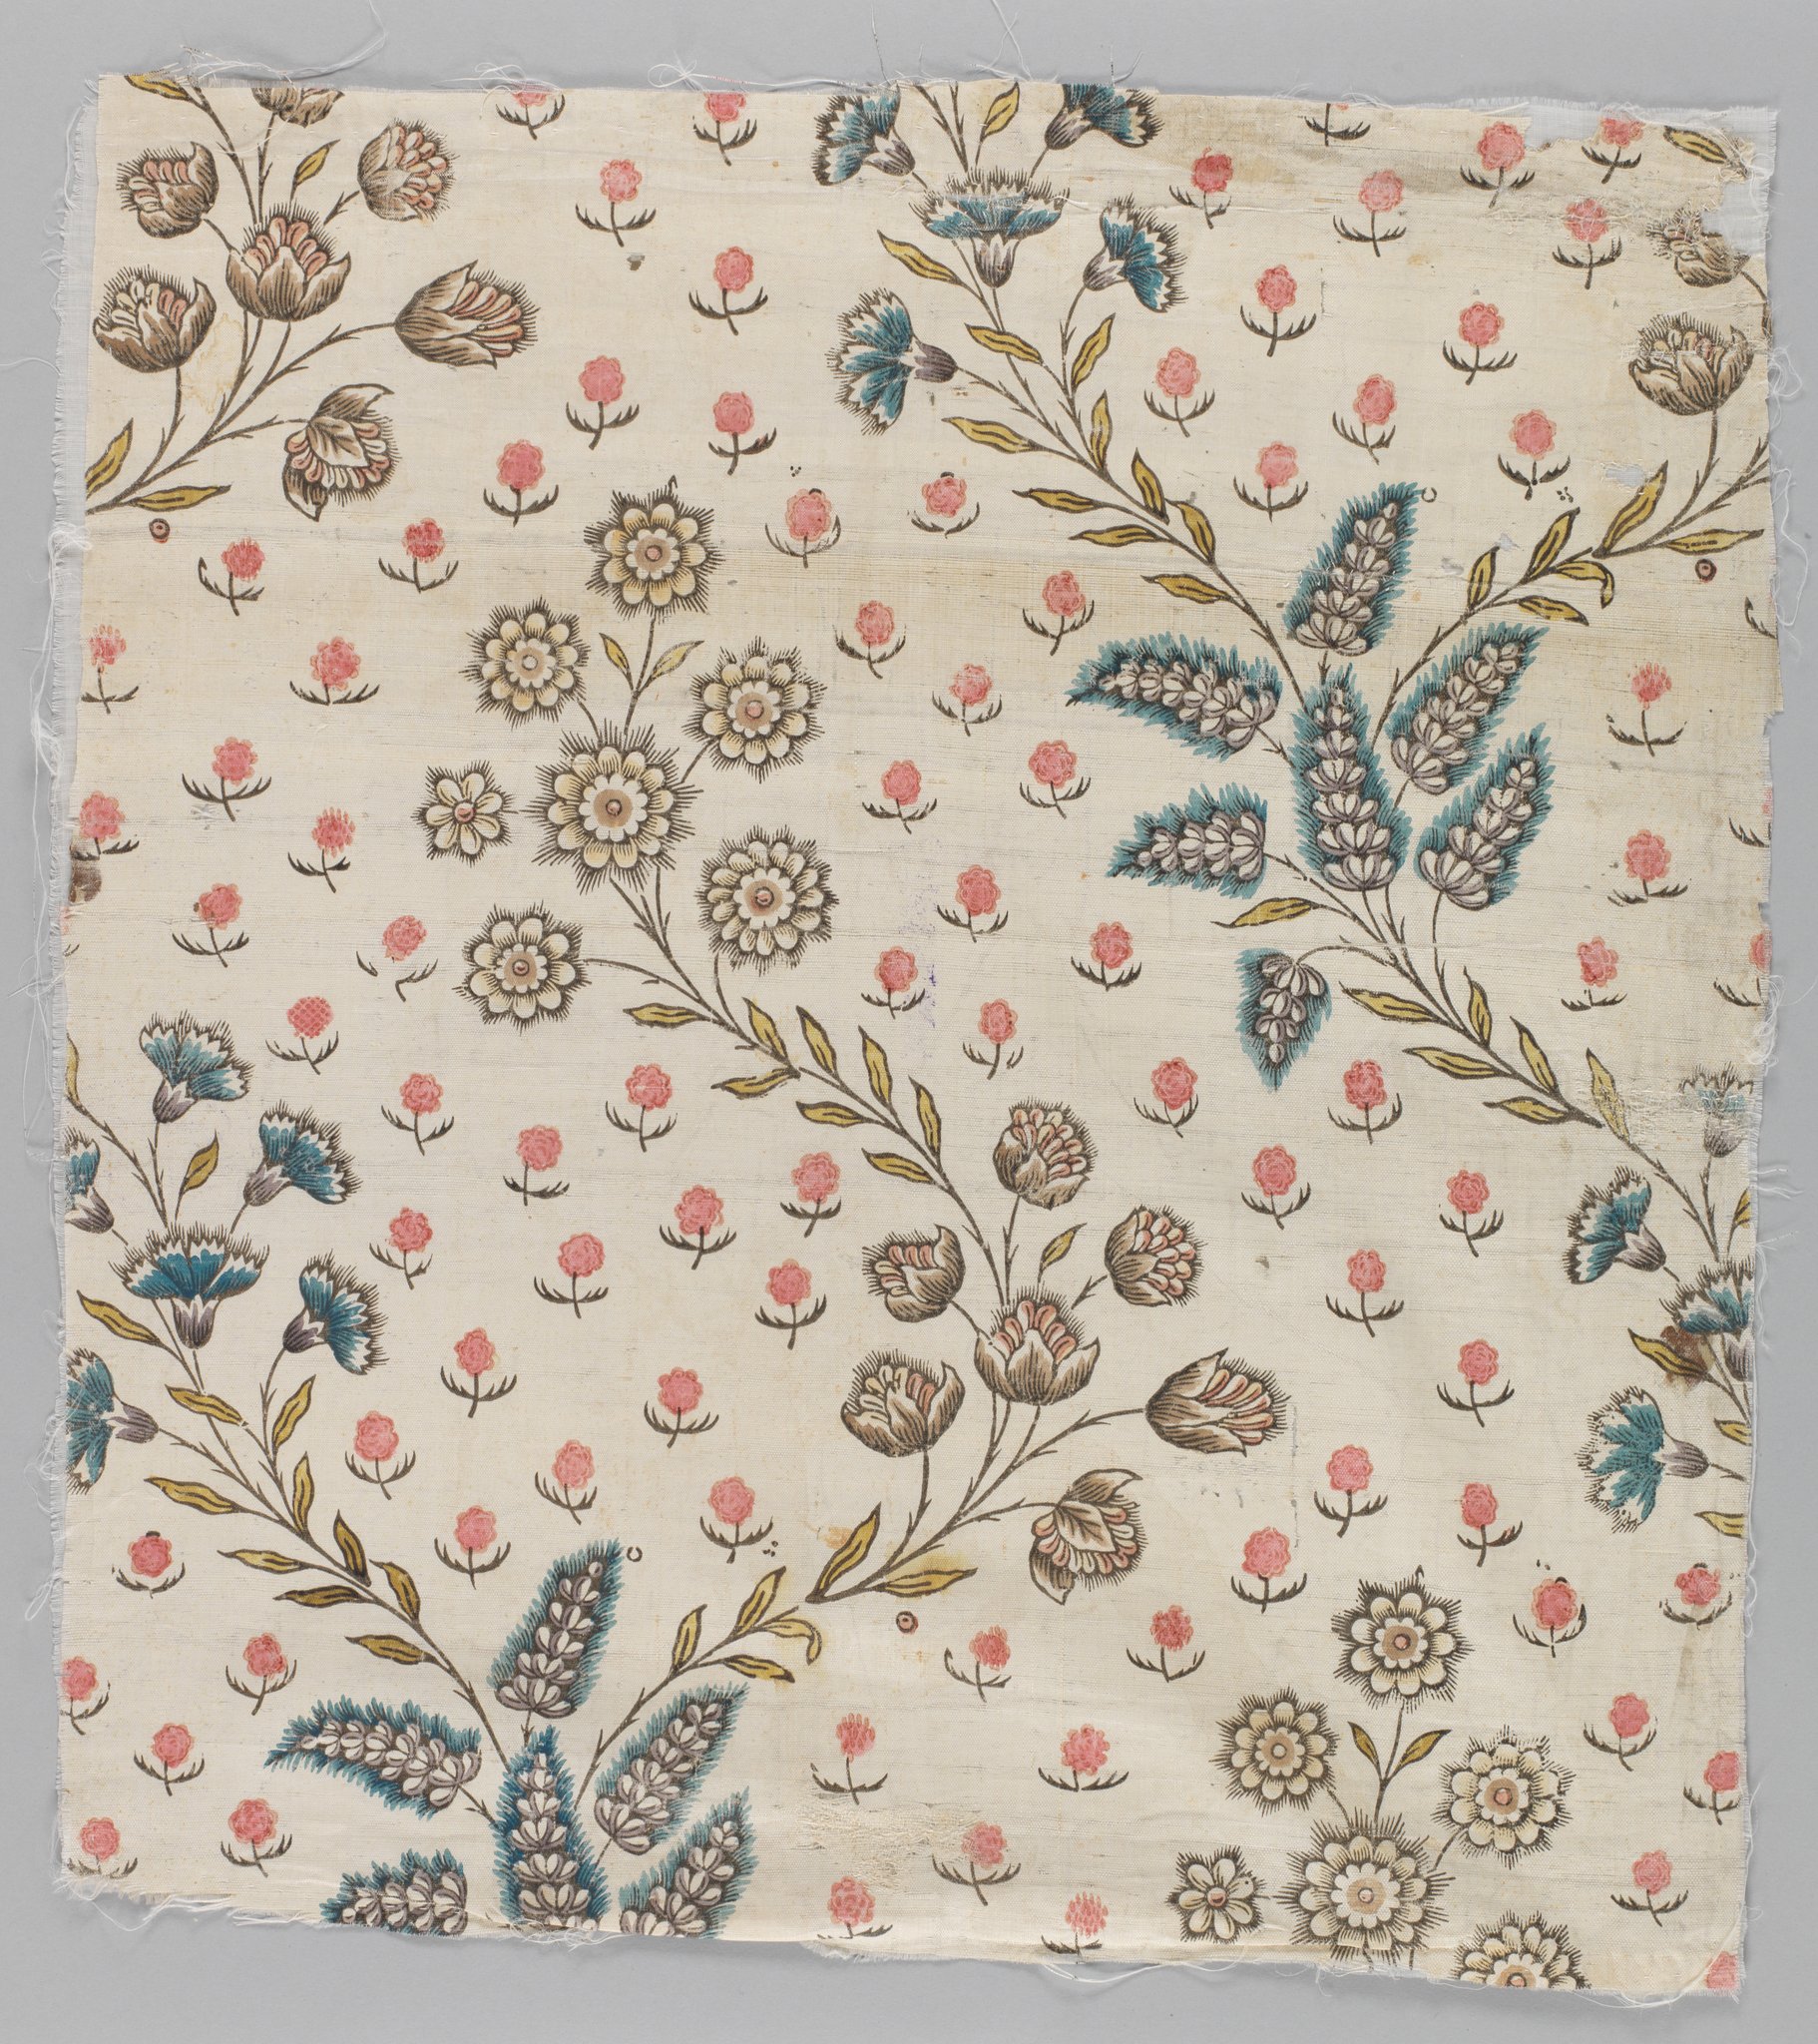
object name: piece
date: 1801-1900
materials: cotton